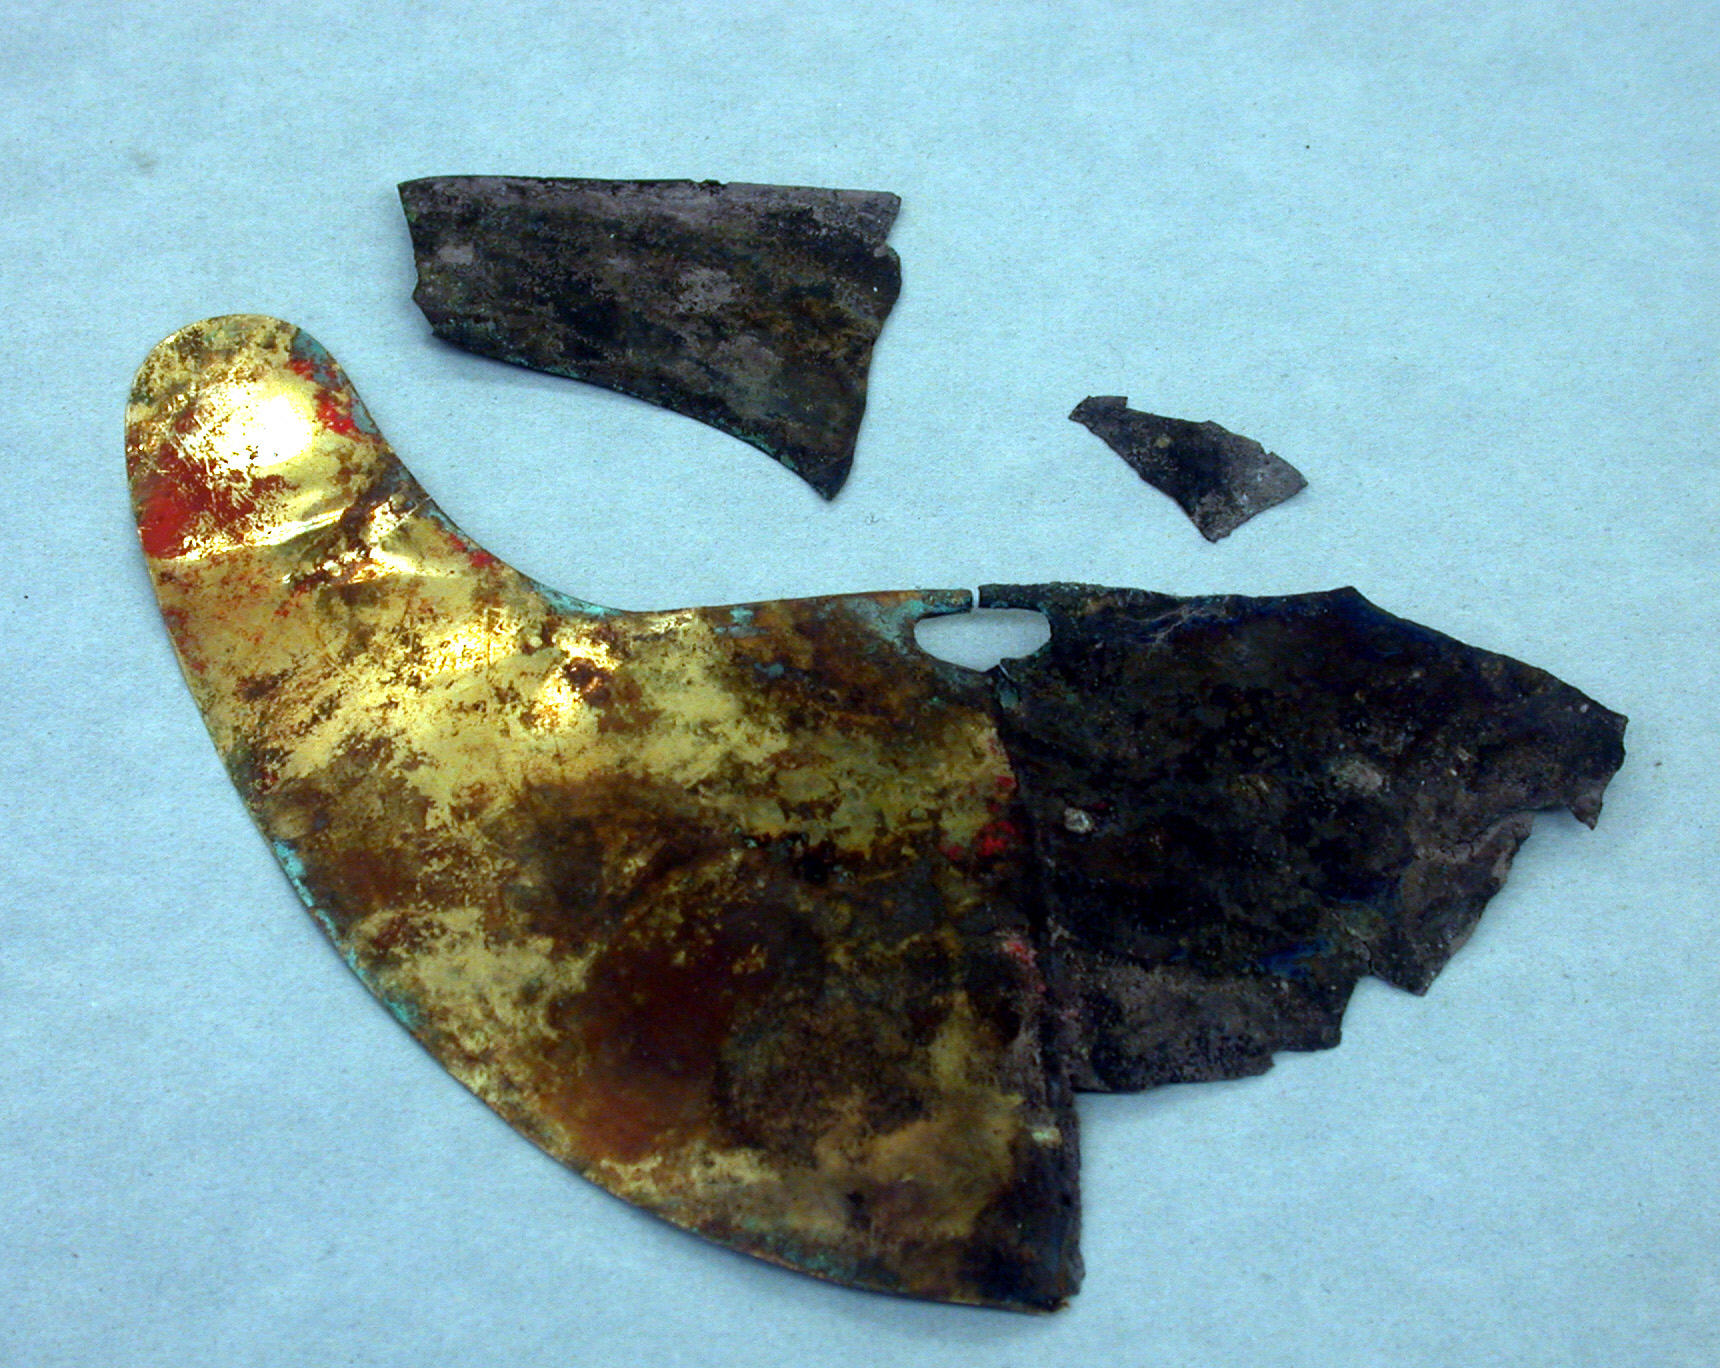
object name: nose ornament fragment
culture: moche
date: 501-700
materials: gold, silver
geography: peru